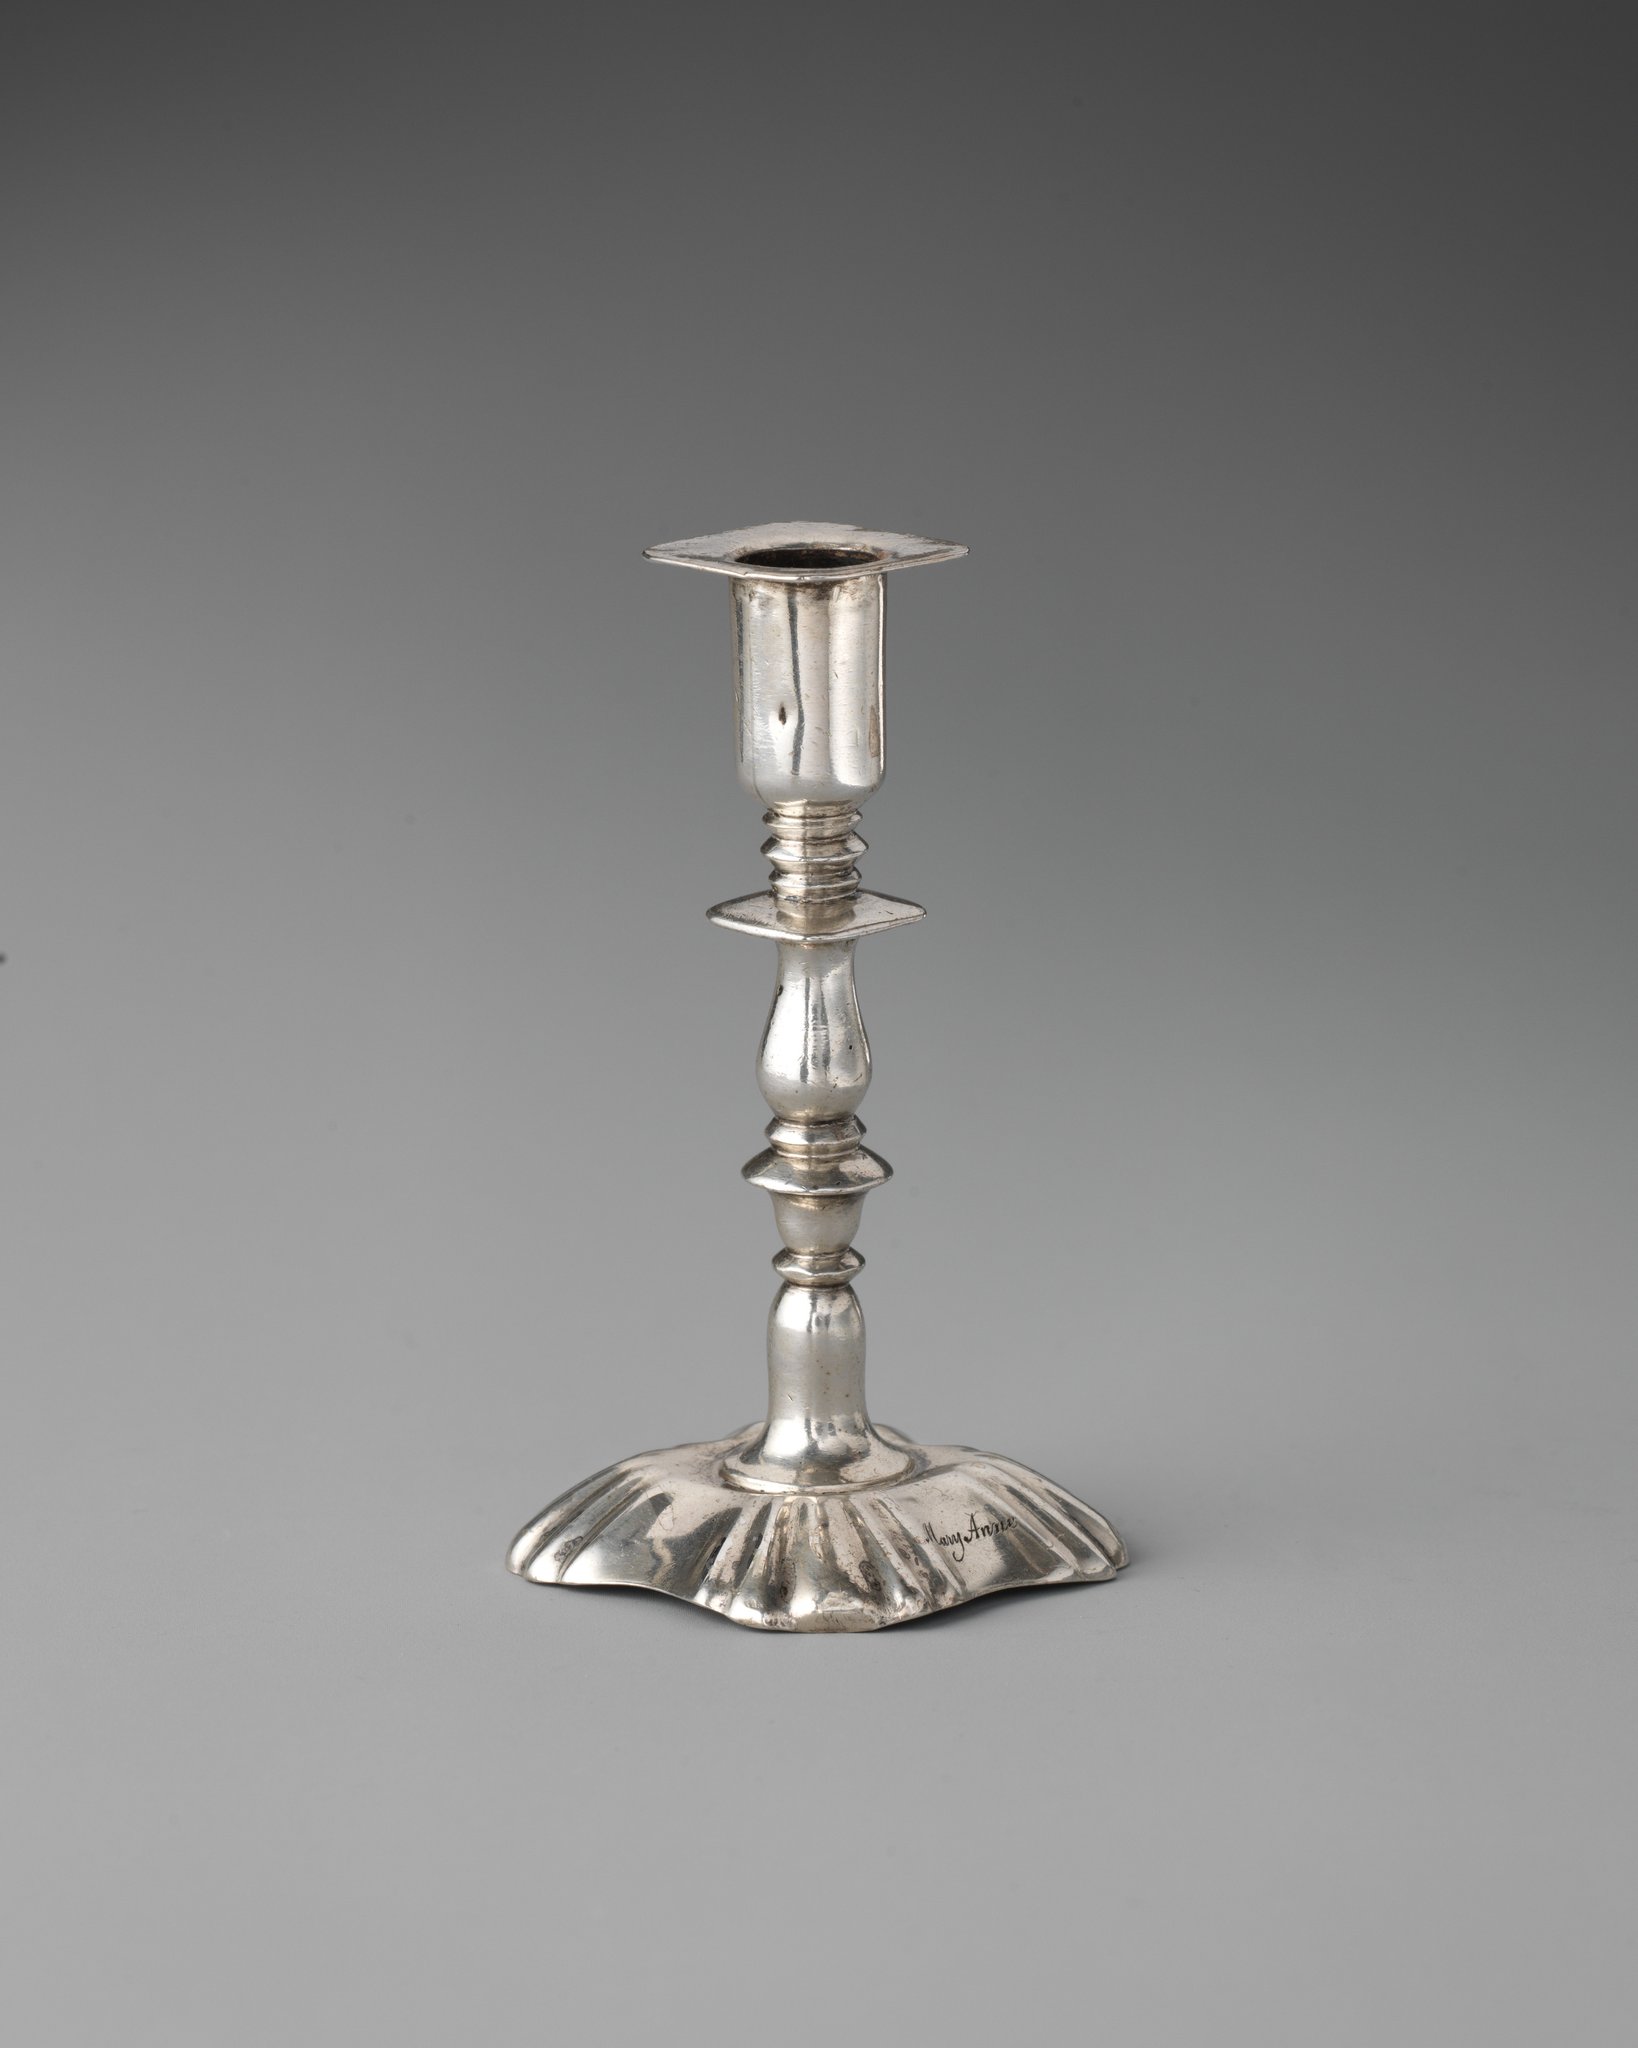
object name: candlestick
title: Miniature candlestick (one of a pair)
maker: henry flavelle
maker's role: artist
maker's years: 1750-1850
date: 1828-1829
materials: silver